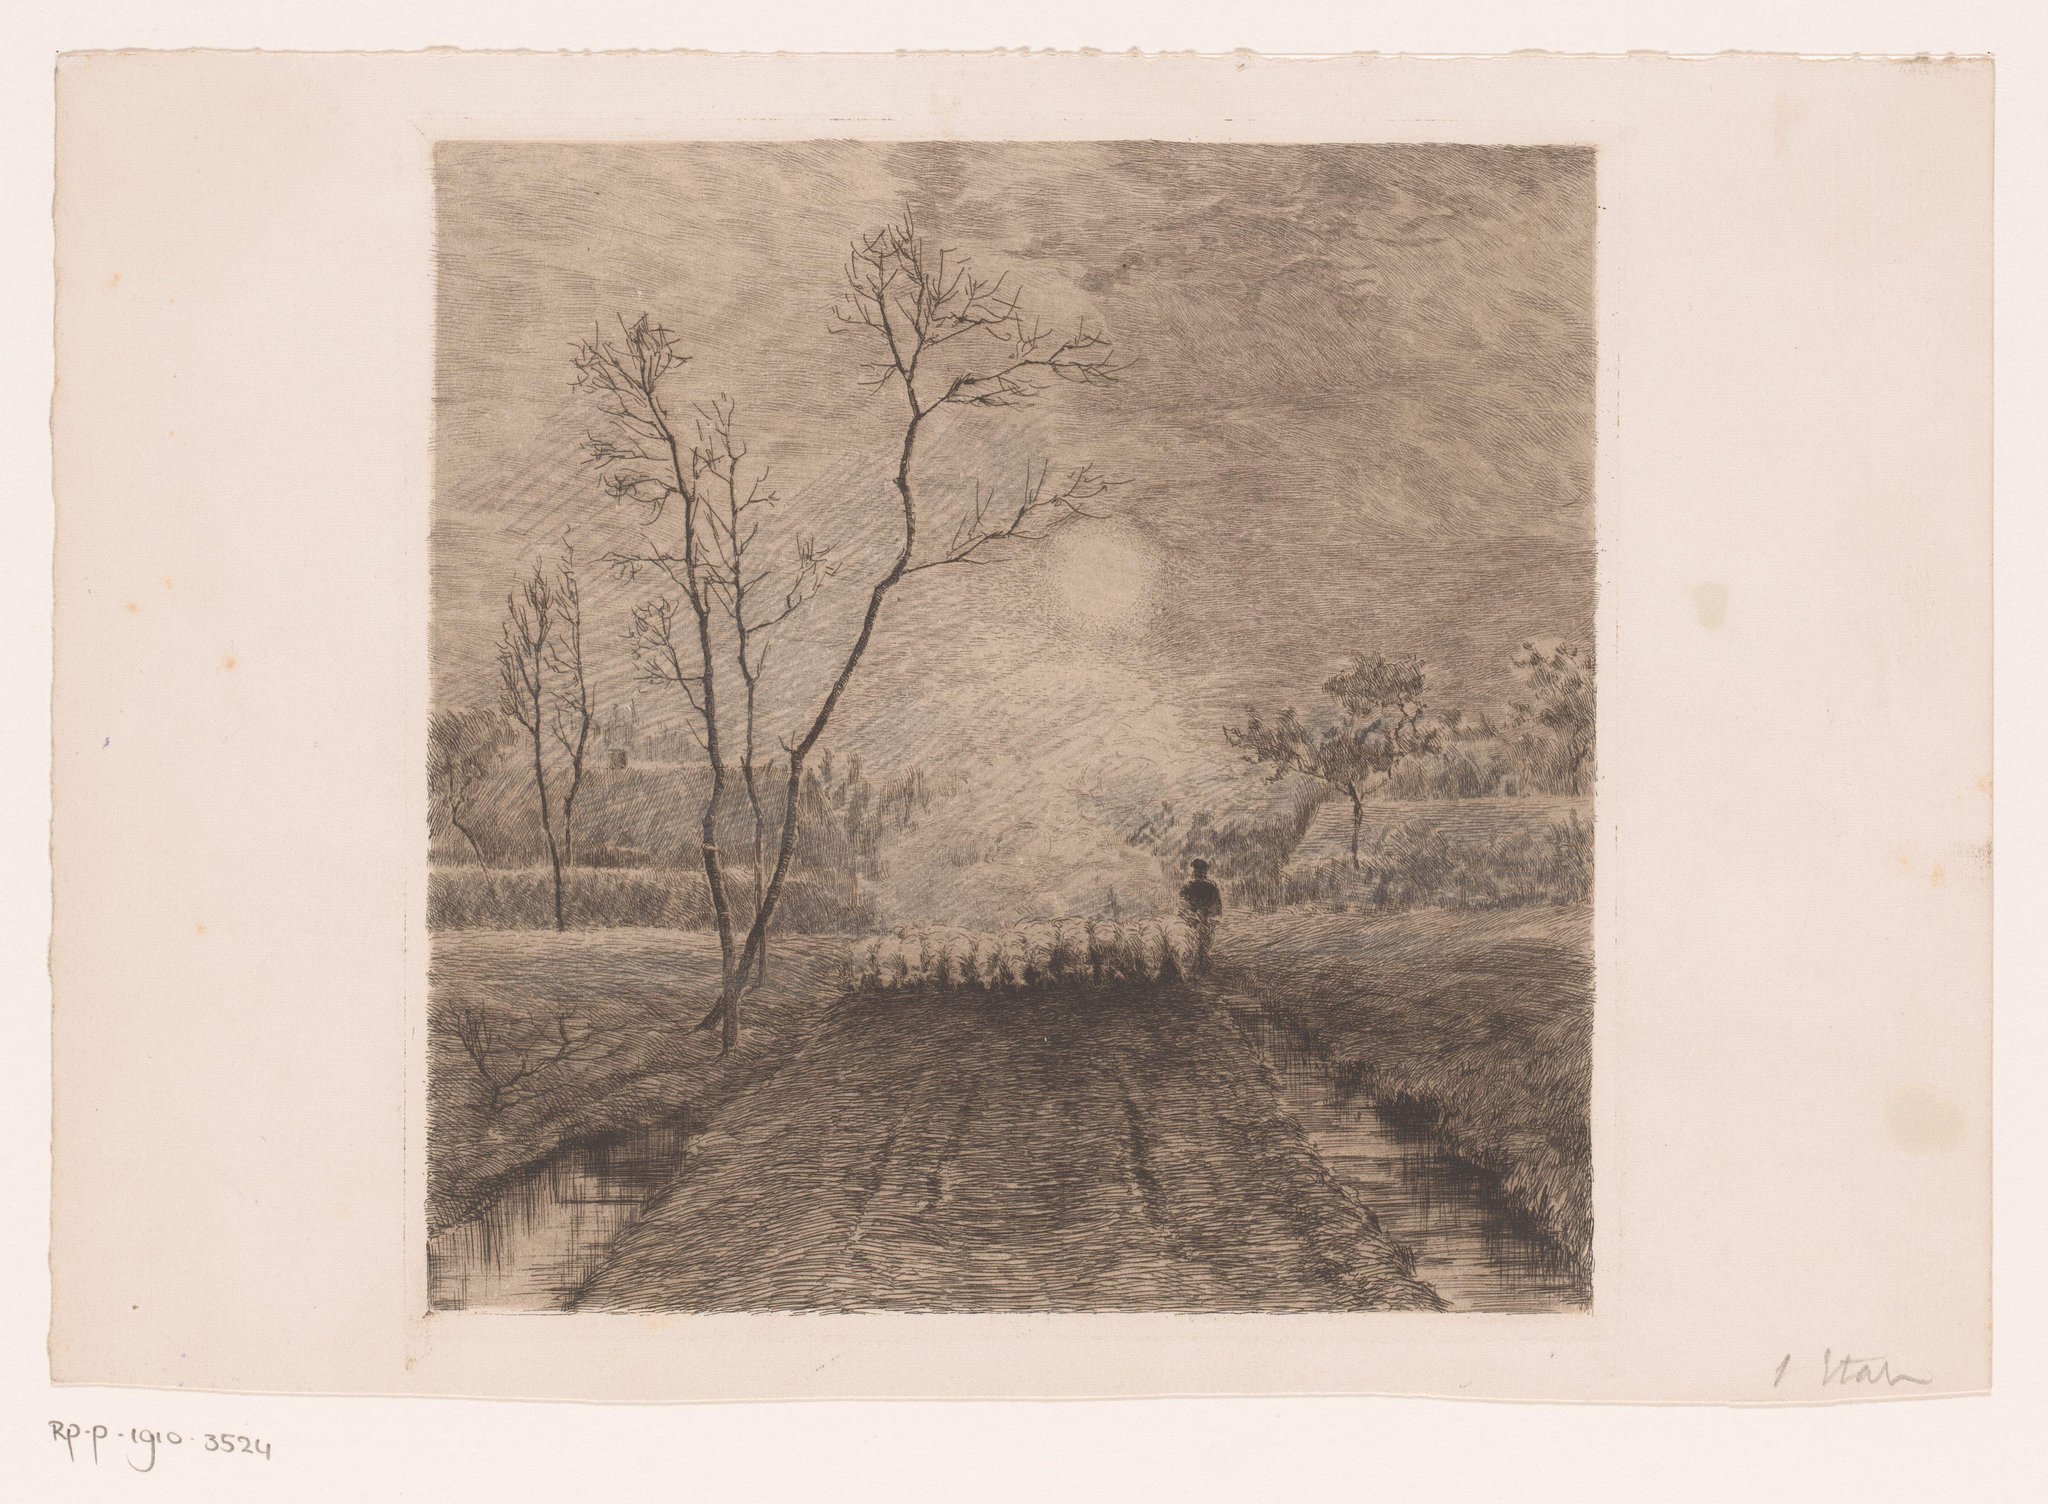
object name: print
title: Kudde schapen en hun herder onder maanlicht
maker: jules guiette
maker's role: print maker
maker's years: 1852-1901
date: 1862-1901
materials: paper, pencil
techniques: drawing, etching, intaglio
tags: moonlight, herd, flock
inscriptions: annotation: ‘1 Etat’, collector's mark: Lugt 2228